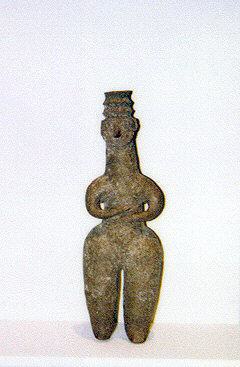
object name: vessel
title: Anthropomorphic vessel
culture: iranian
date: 900-601 BCE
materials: ceramic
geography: northwestern iran